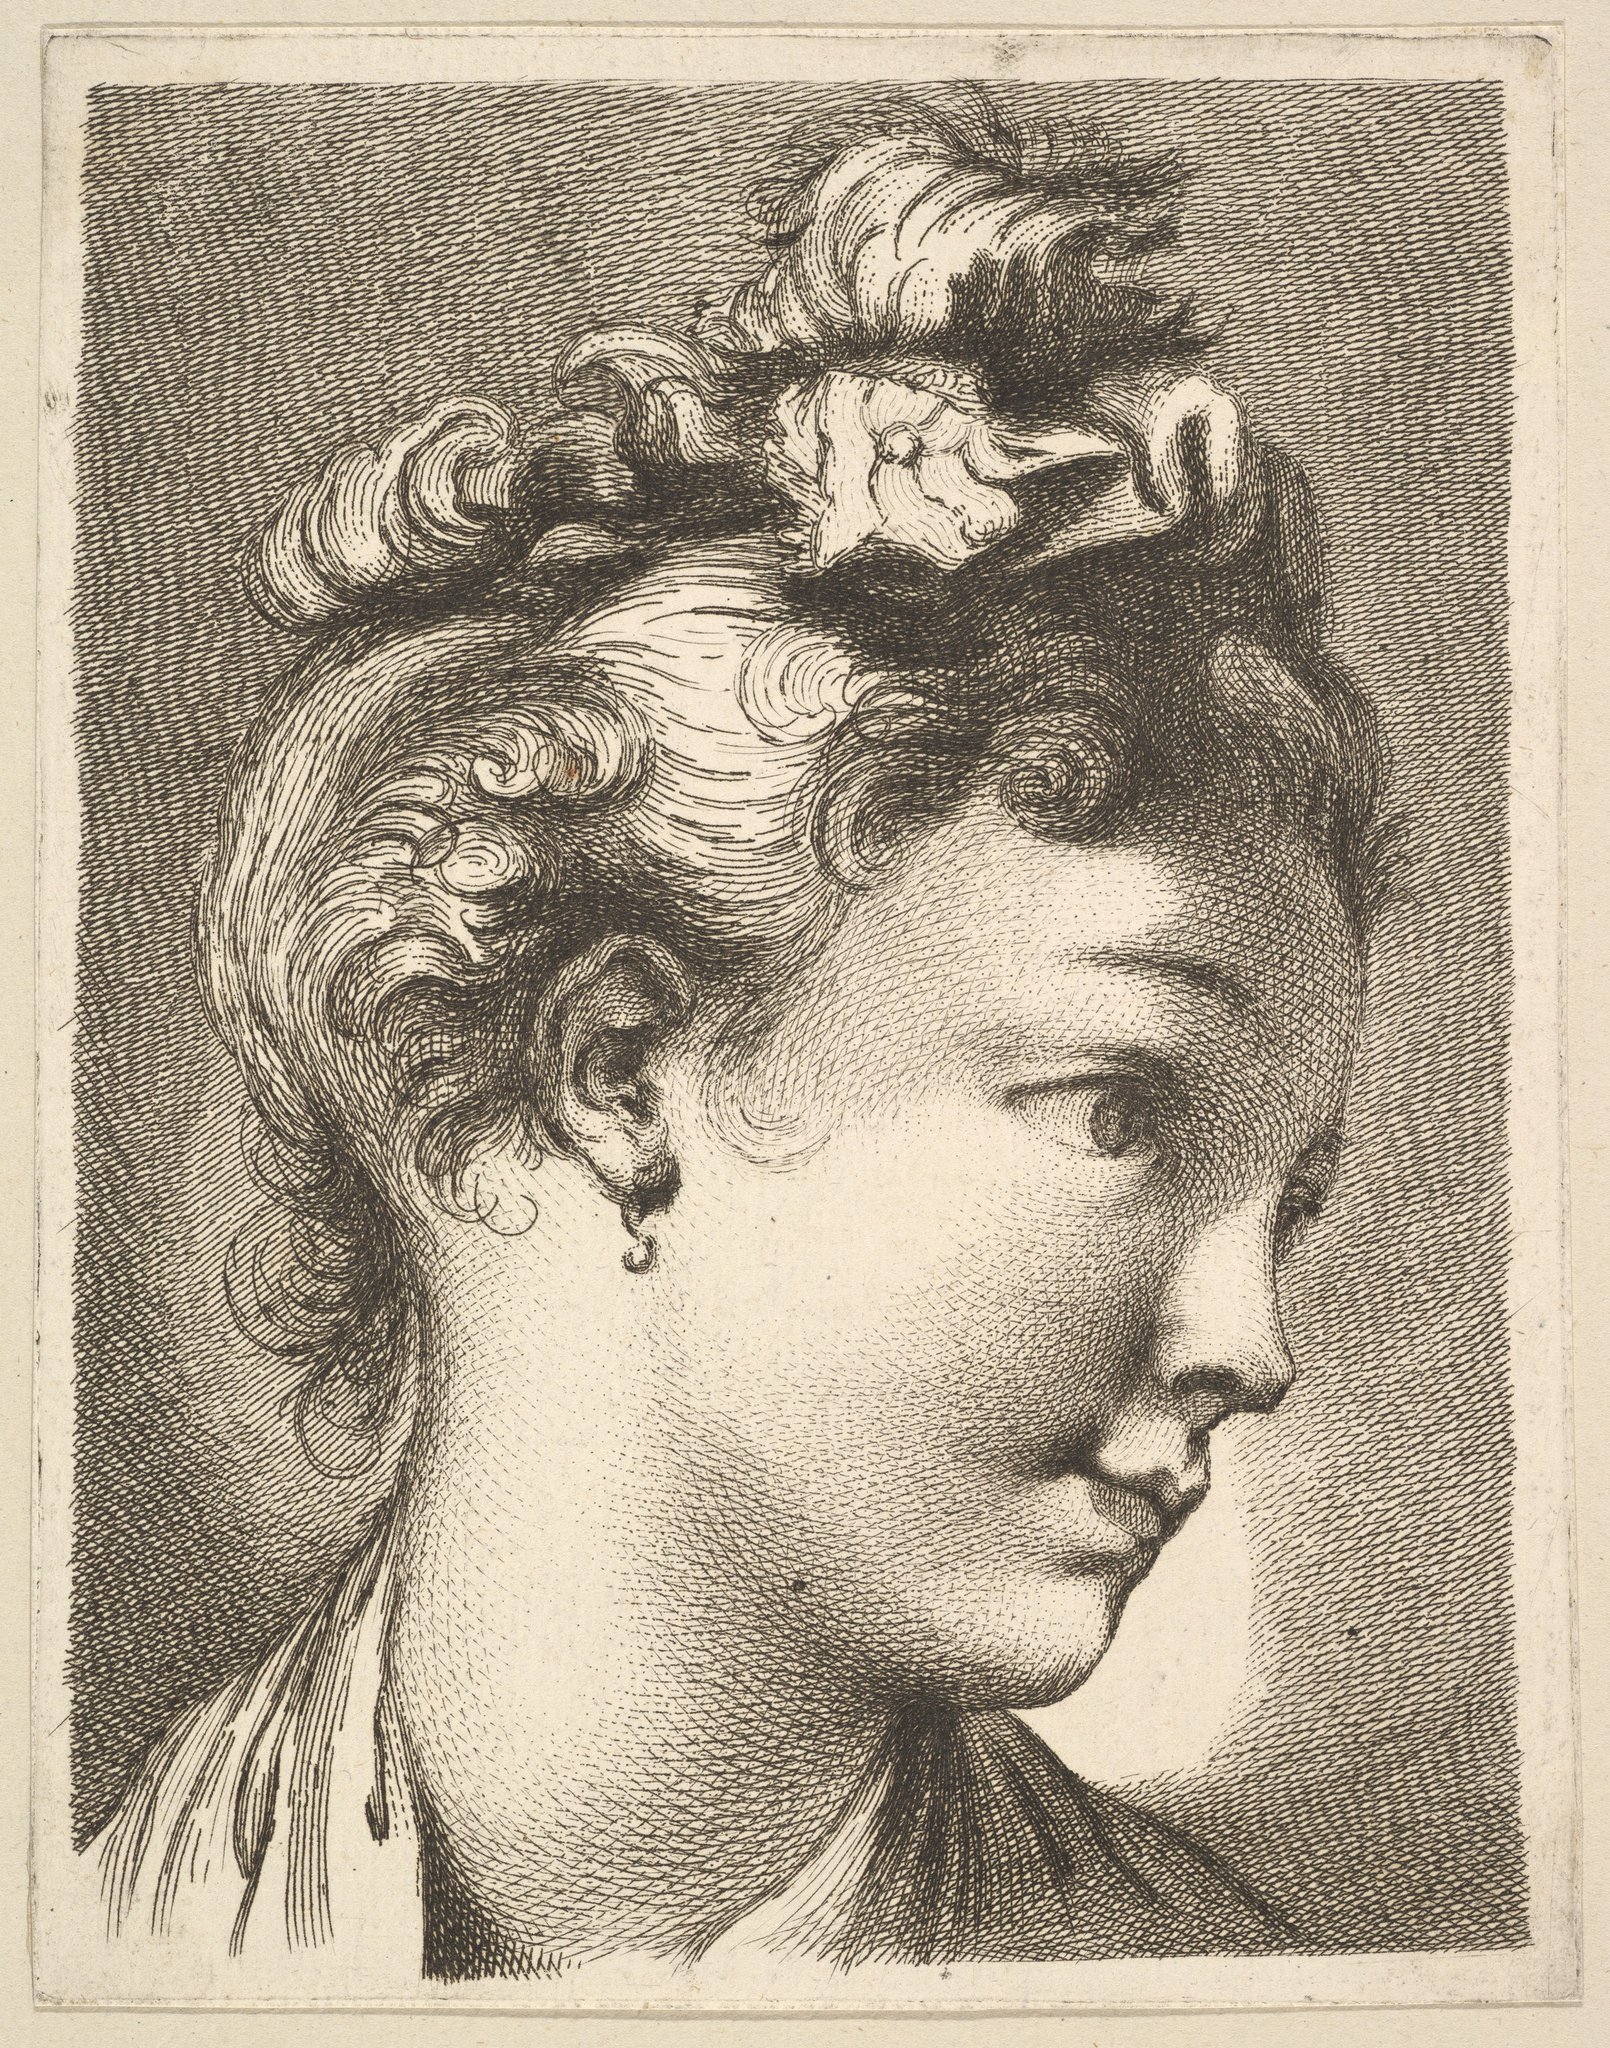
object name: print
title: Head of a woman with her head turned to the left, from Livre de Têtes Gravées d'apres F. Boucher et Autres (Book of Heads Engraved after F. Boucher and Others)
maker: anonymous, french, 18th century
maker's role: artist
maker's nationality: french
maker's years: 1700-1800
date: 1701-1800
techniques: engraving, etching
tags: heads,women